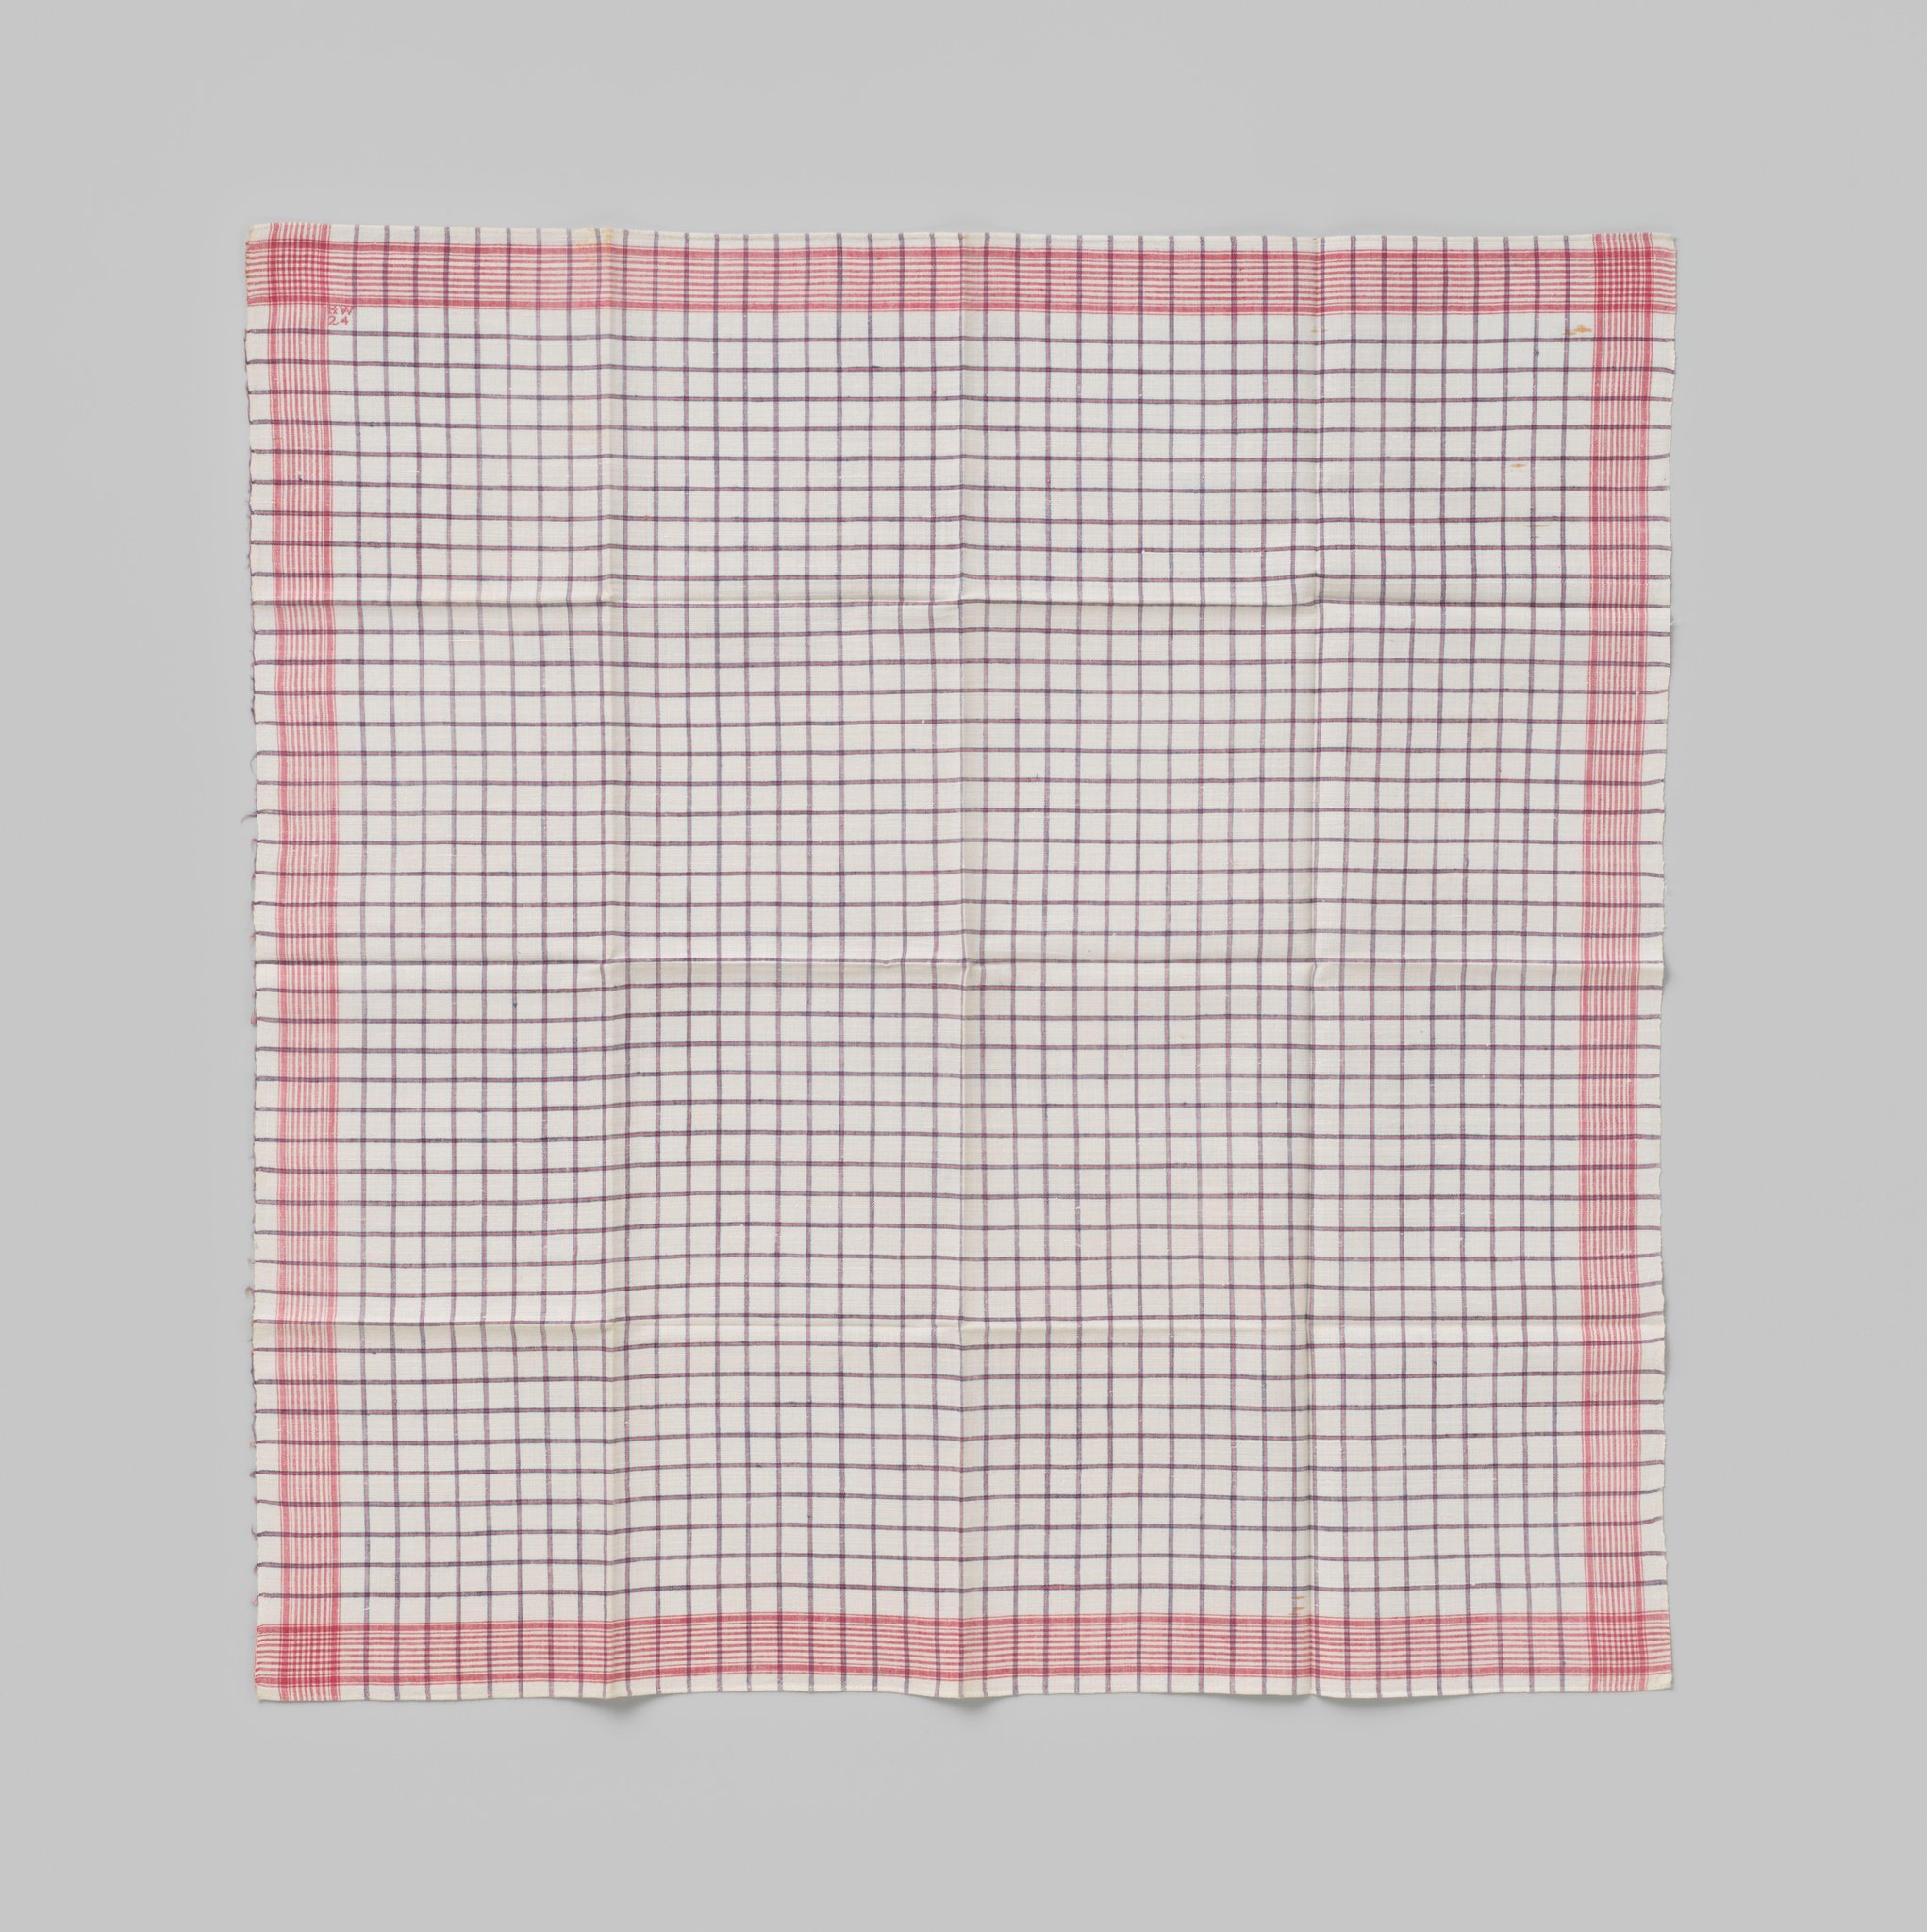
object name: kitchen towel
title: Theedoek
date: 1831-1850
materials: linen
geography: netherlands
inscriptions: mark: ‘HW 24’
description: Theedoek van linnen, grote blauwe ruit met rode randen. Merk HW24.